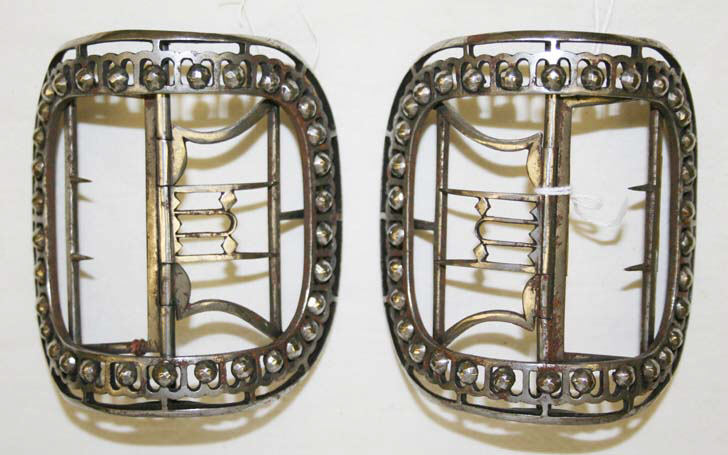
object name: shoe buckle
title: Shoe buckles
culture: european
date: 1767-1800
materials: steel